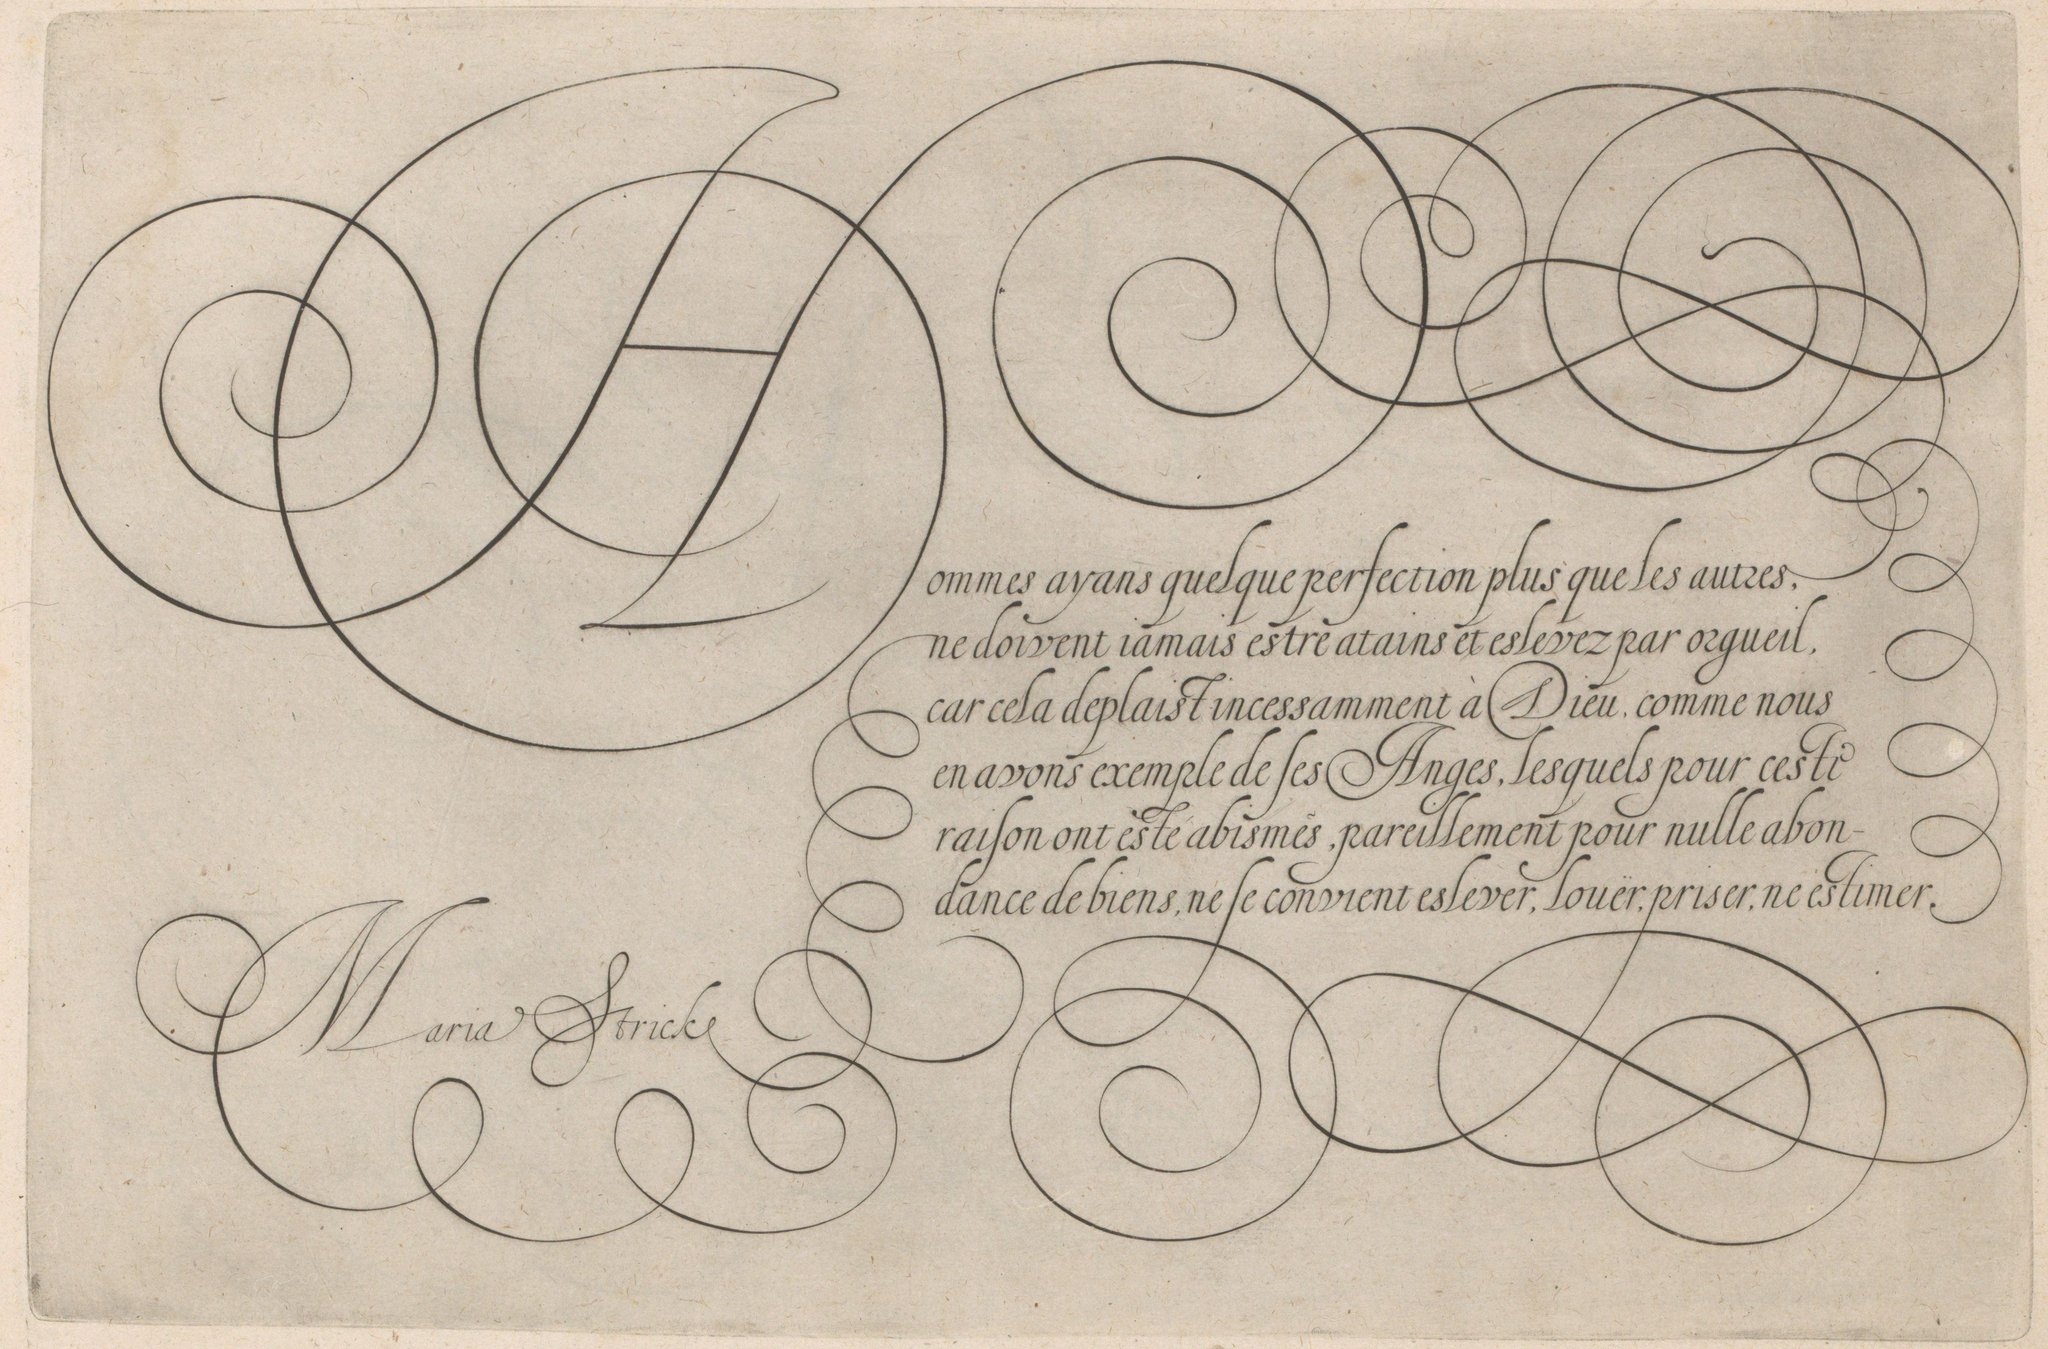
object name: print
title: Schat oft voorbeelt ende verthooninge van verscheyden geschriften (...)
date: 1618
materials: paper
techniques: engraving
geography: rotterdam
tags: calligraphy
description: Schrijfvoorbeeld in het Frans met kapitaal H en zes regels tekst: Homme ayans quelque perfection (...). Omlijst door kalligrafisch krulwerk. De prent maakt deel uit van een album.